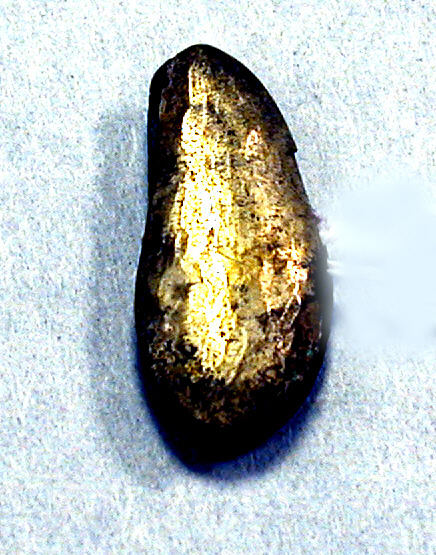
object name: ornament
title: Hammered Silver Pod Ornament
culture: peruvian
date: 701-1566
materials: gilt, silver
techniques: hammering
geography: peru